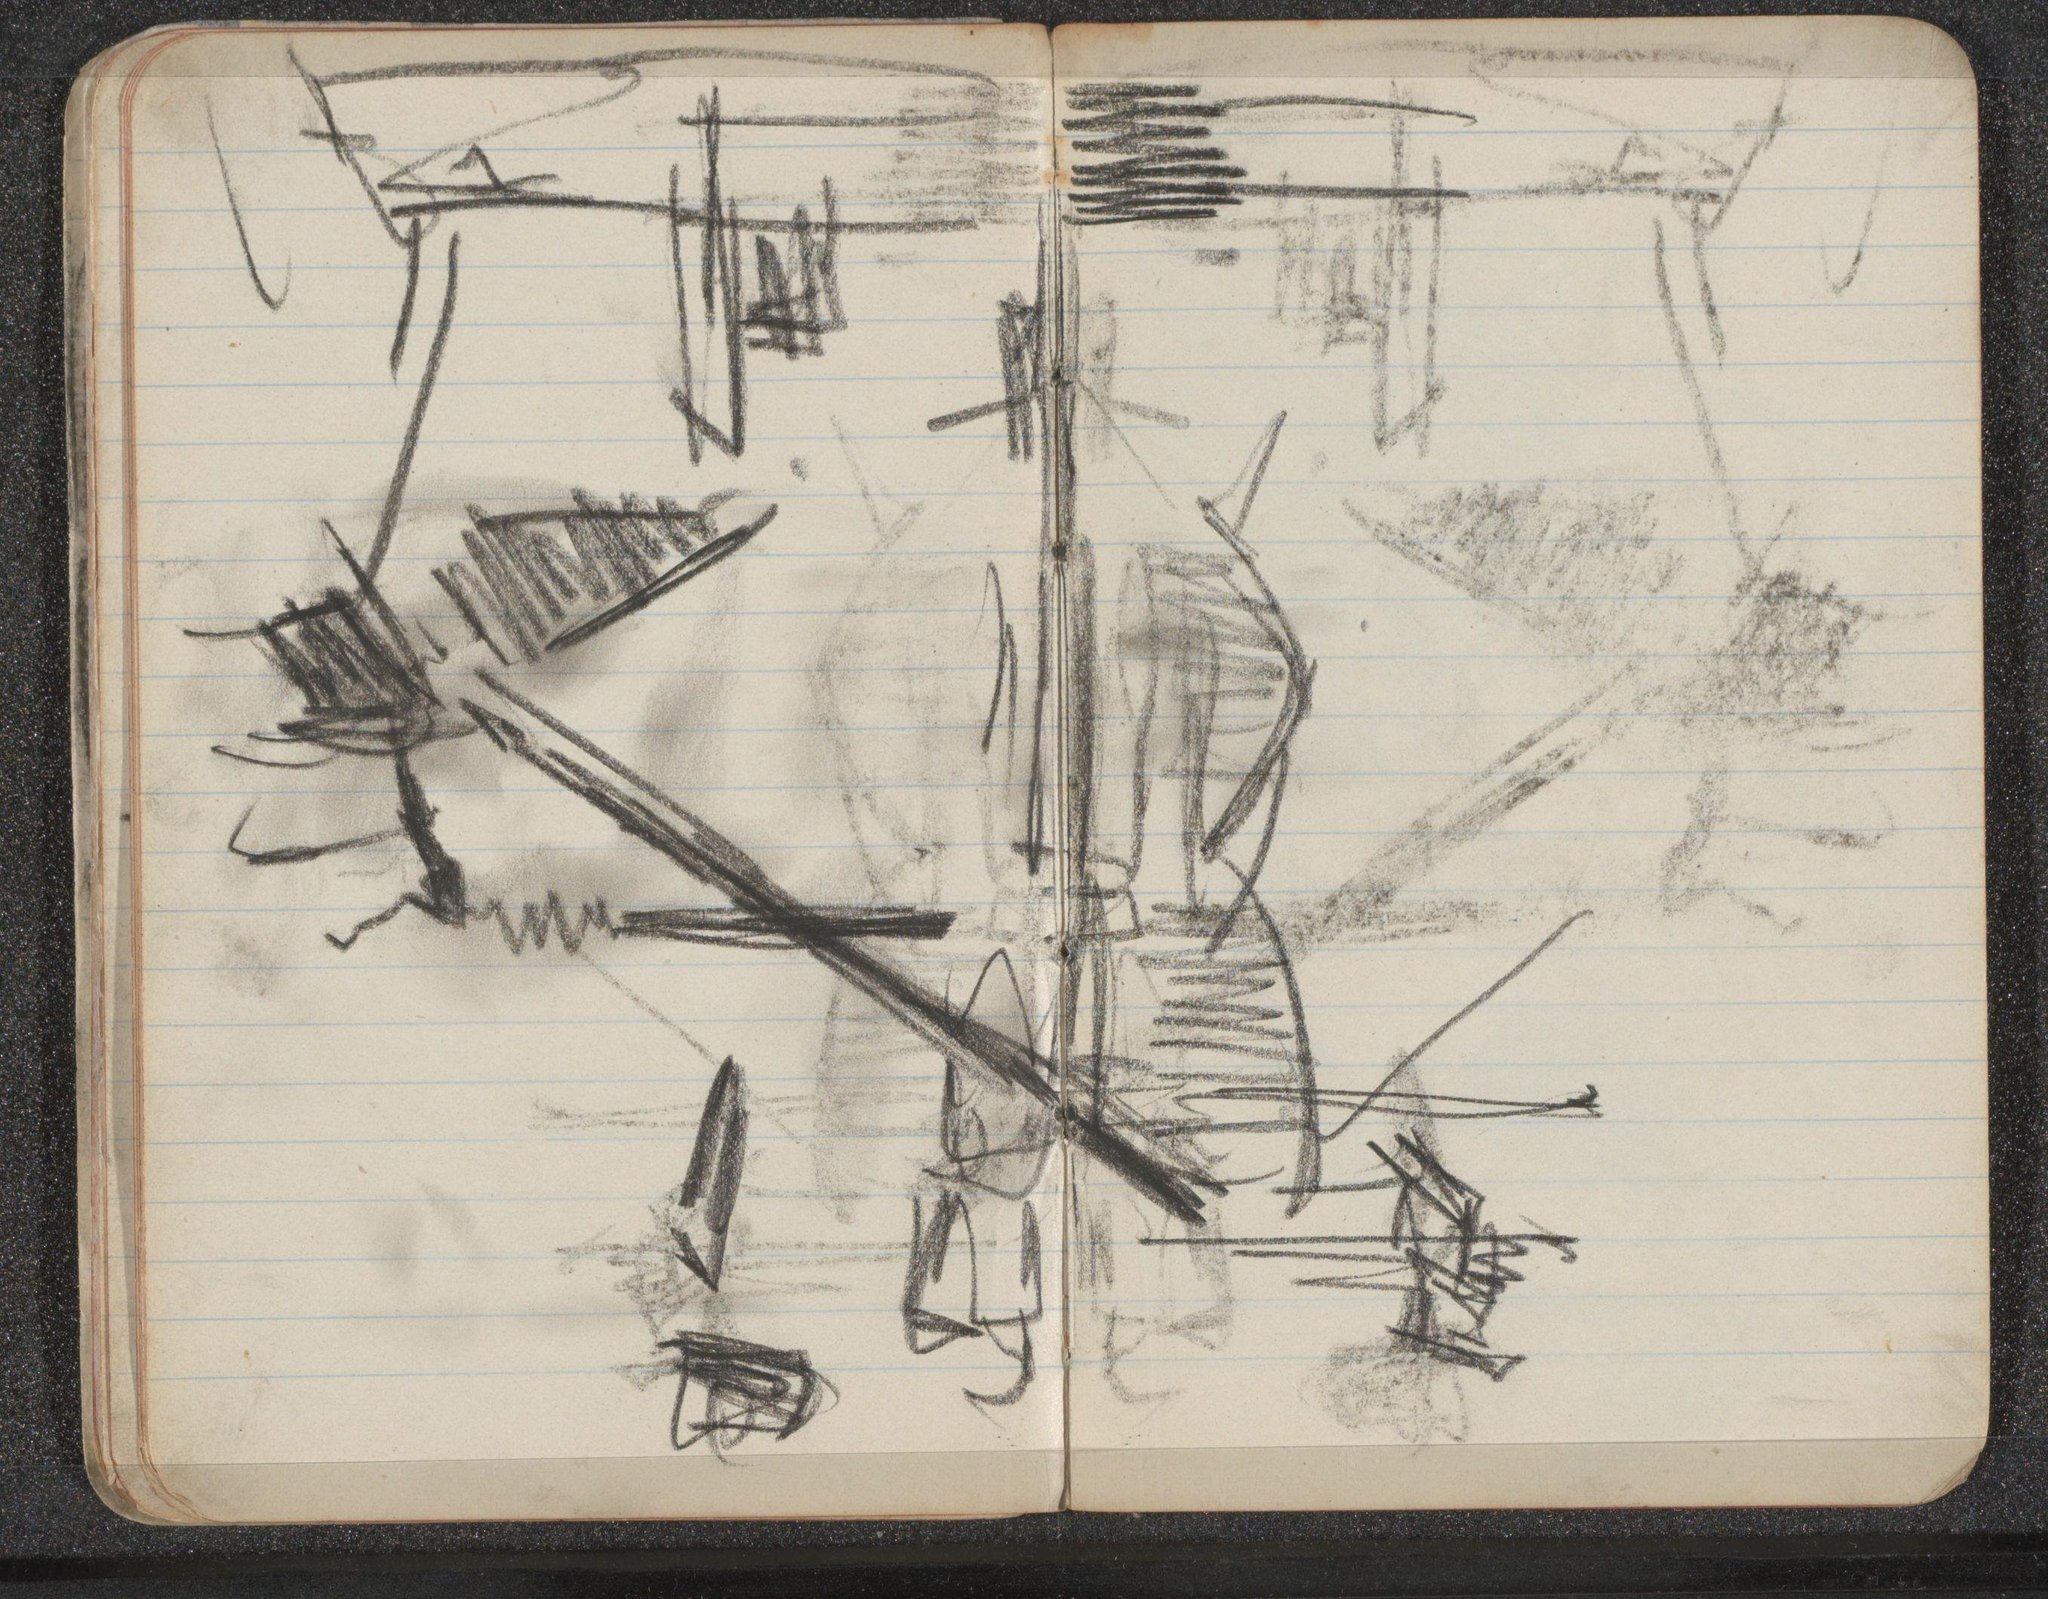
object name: sketchbook leaf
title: Stadsgezicht, mogelijk in Amsterdam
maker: george hendrik breitner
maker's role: draughtsman, painter, print maker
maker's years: 1857-1923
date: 1893-1894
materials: chalk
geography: amsterdam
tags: city-view, and landscape with man-made constructions, amsterdam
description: Pagina 58 en pagina 59 uit een schetsboek met 36 bladen.